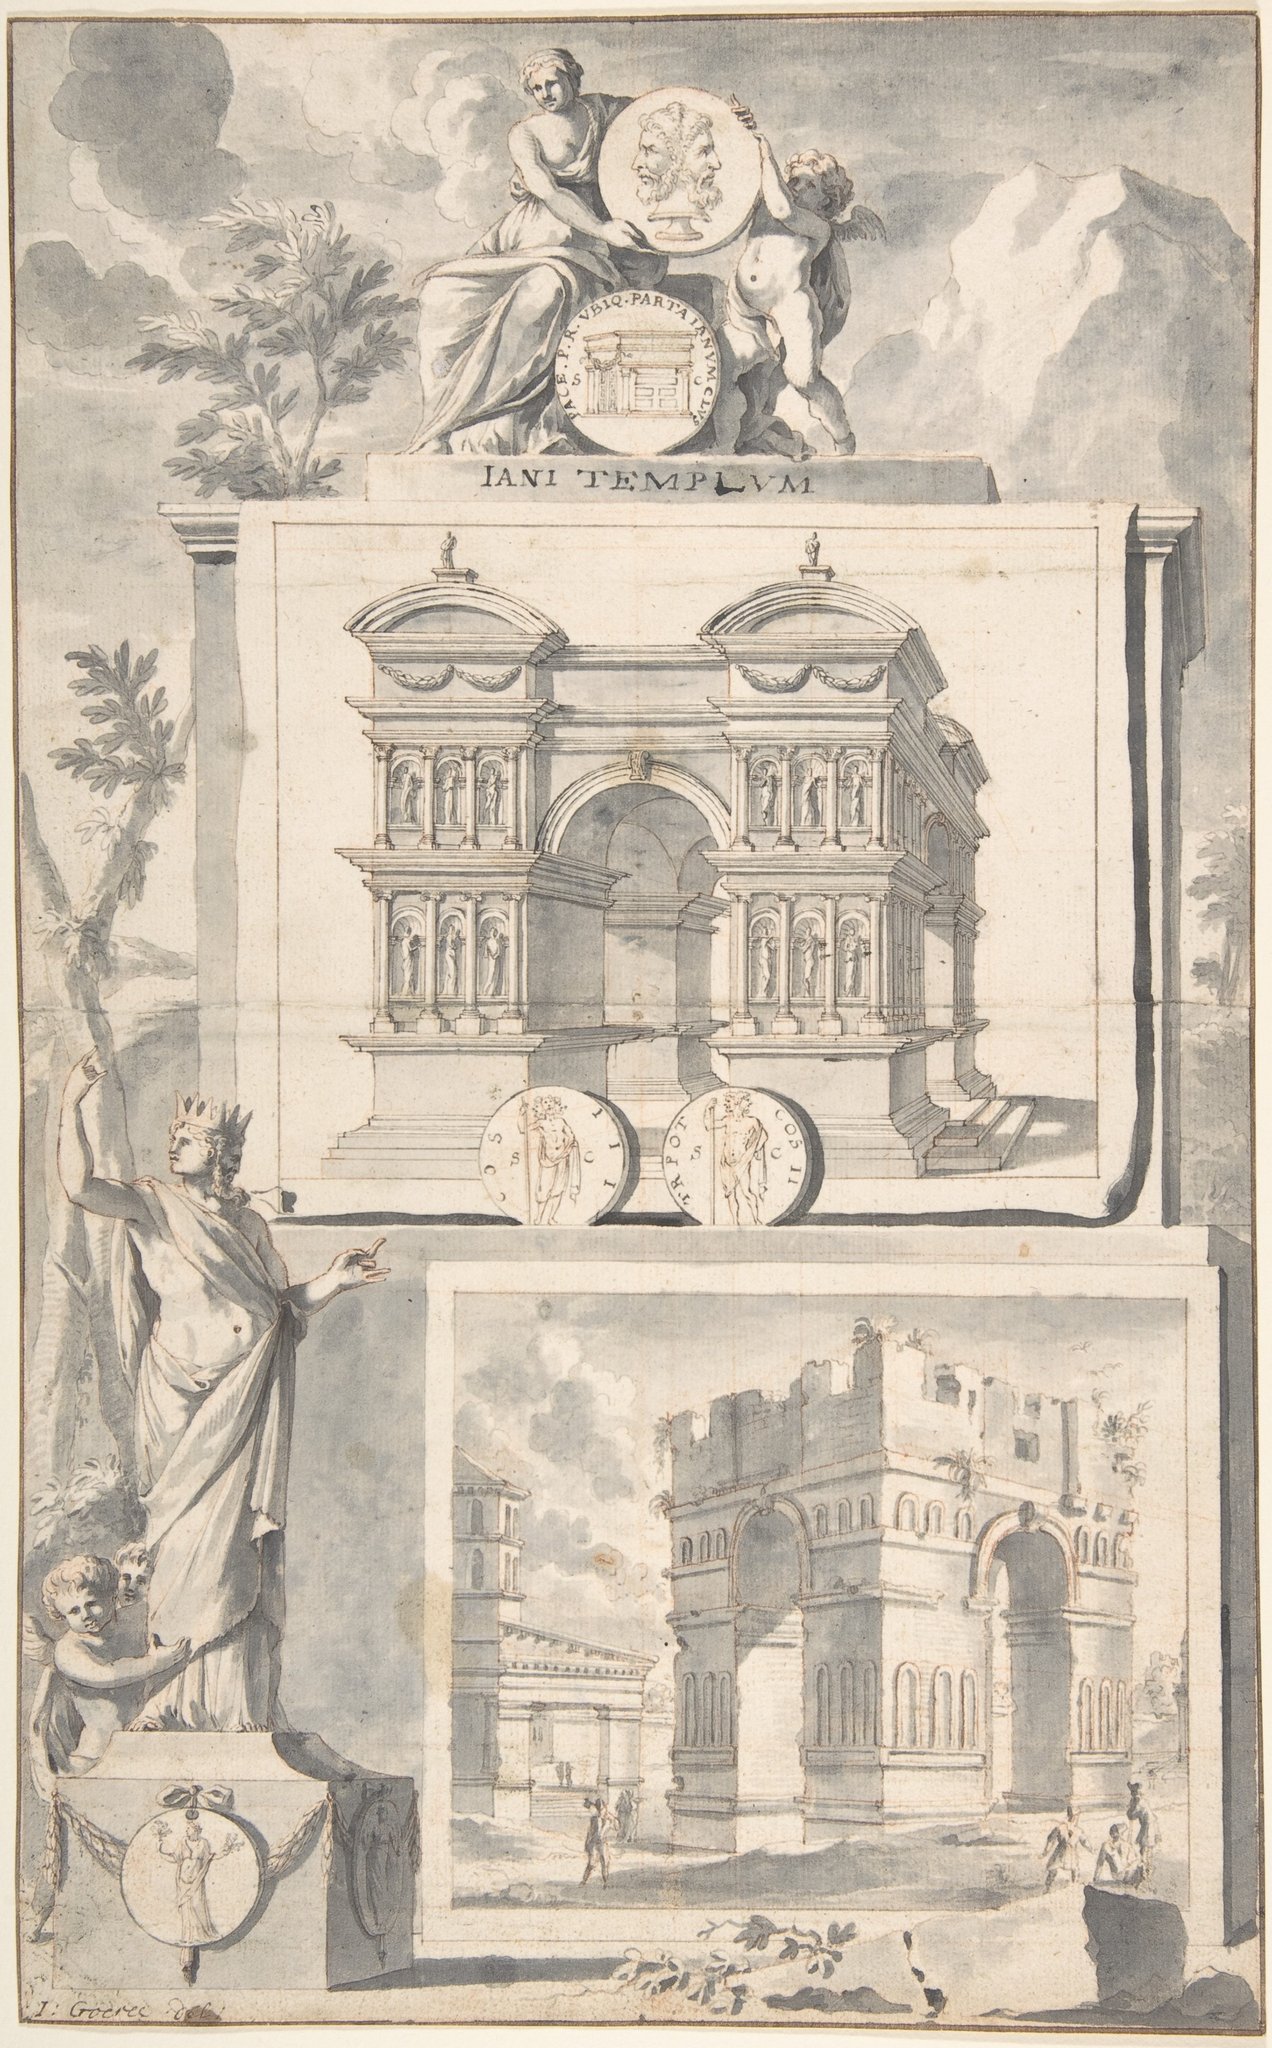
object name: drawing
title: A Reconstruction of the Temple of Janus (above) and a View of the Ruins (below)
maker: jan goeree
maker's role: artist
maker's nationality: dutch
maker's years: 1670-1731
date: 1704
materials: chalk, ink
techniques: brush, pen, wash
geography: italy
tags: temples,ruins,men,women